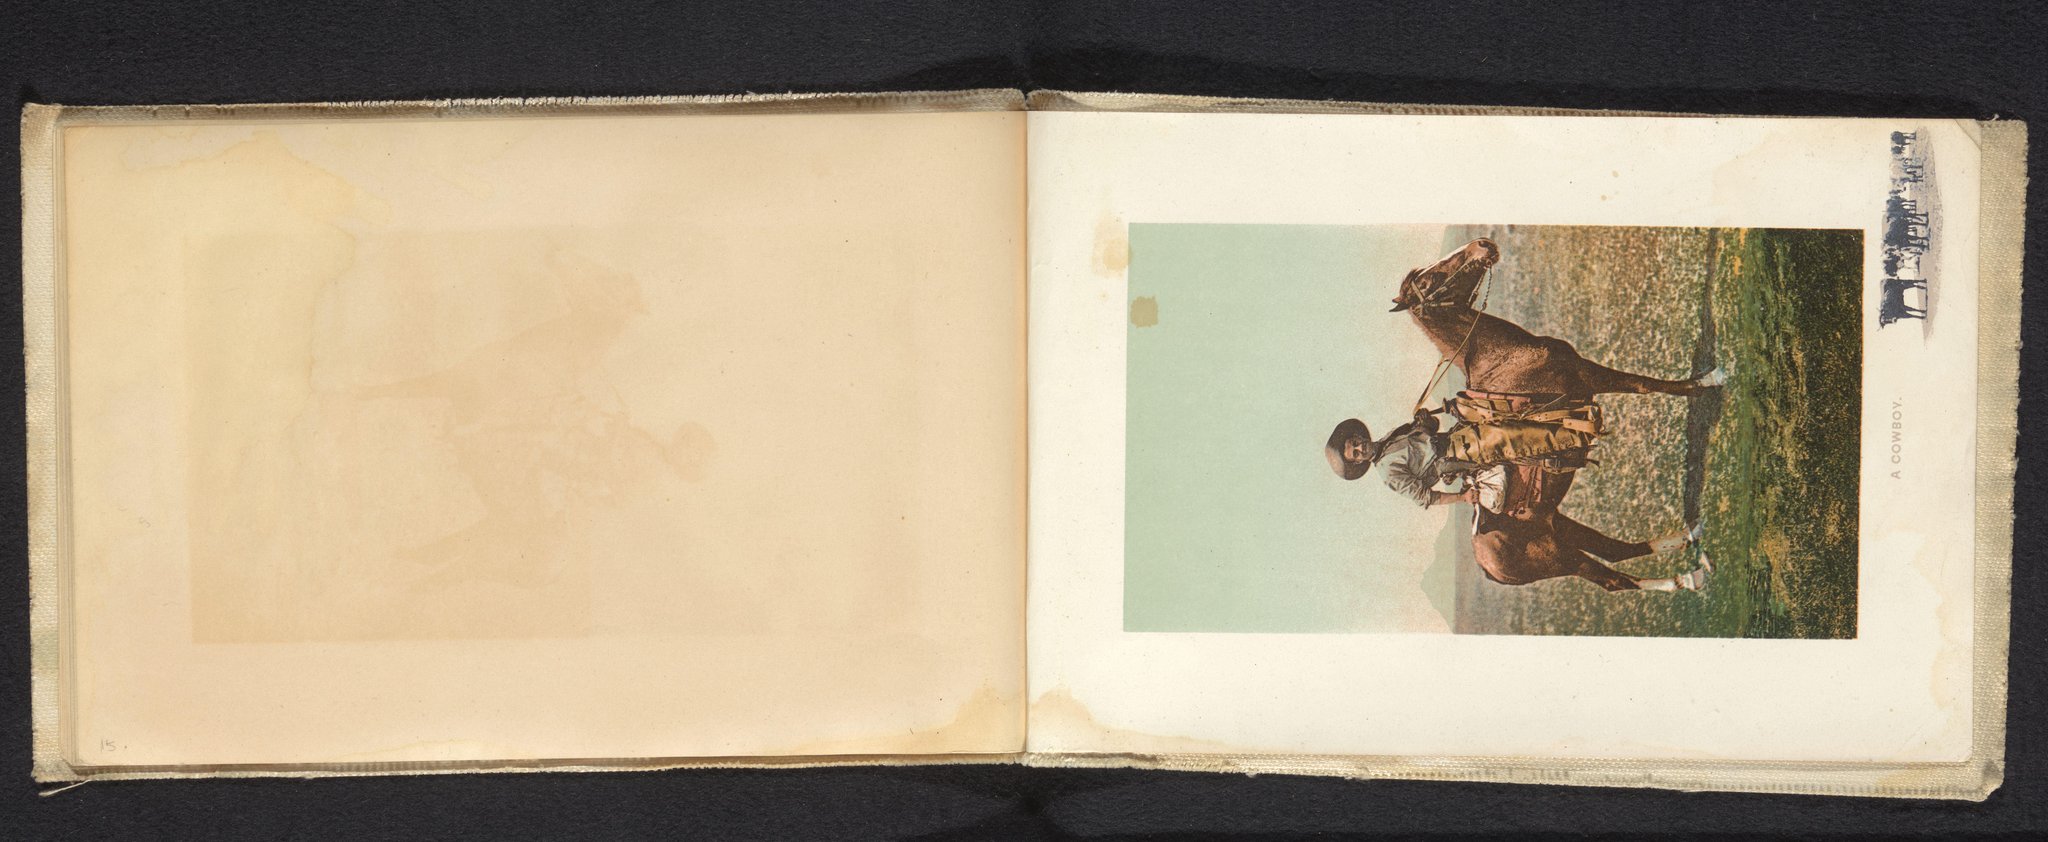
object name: photomechanical print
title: Cowboy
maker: Anonymous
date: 1894-1899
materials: paper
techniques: lithograph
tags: cowboy